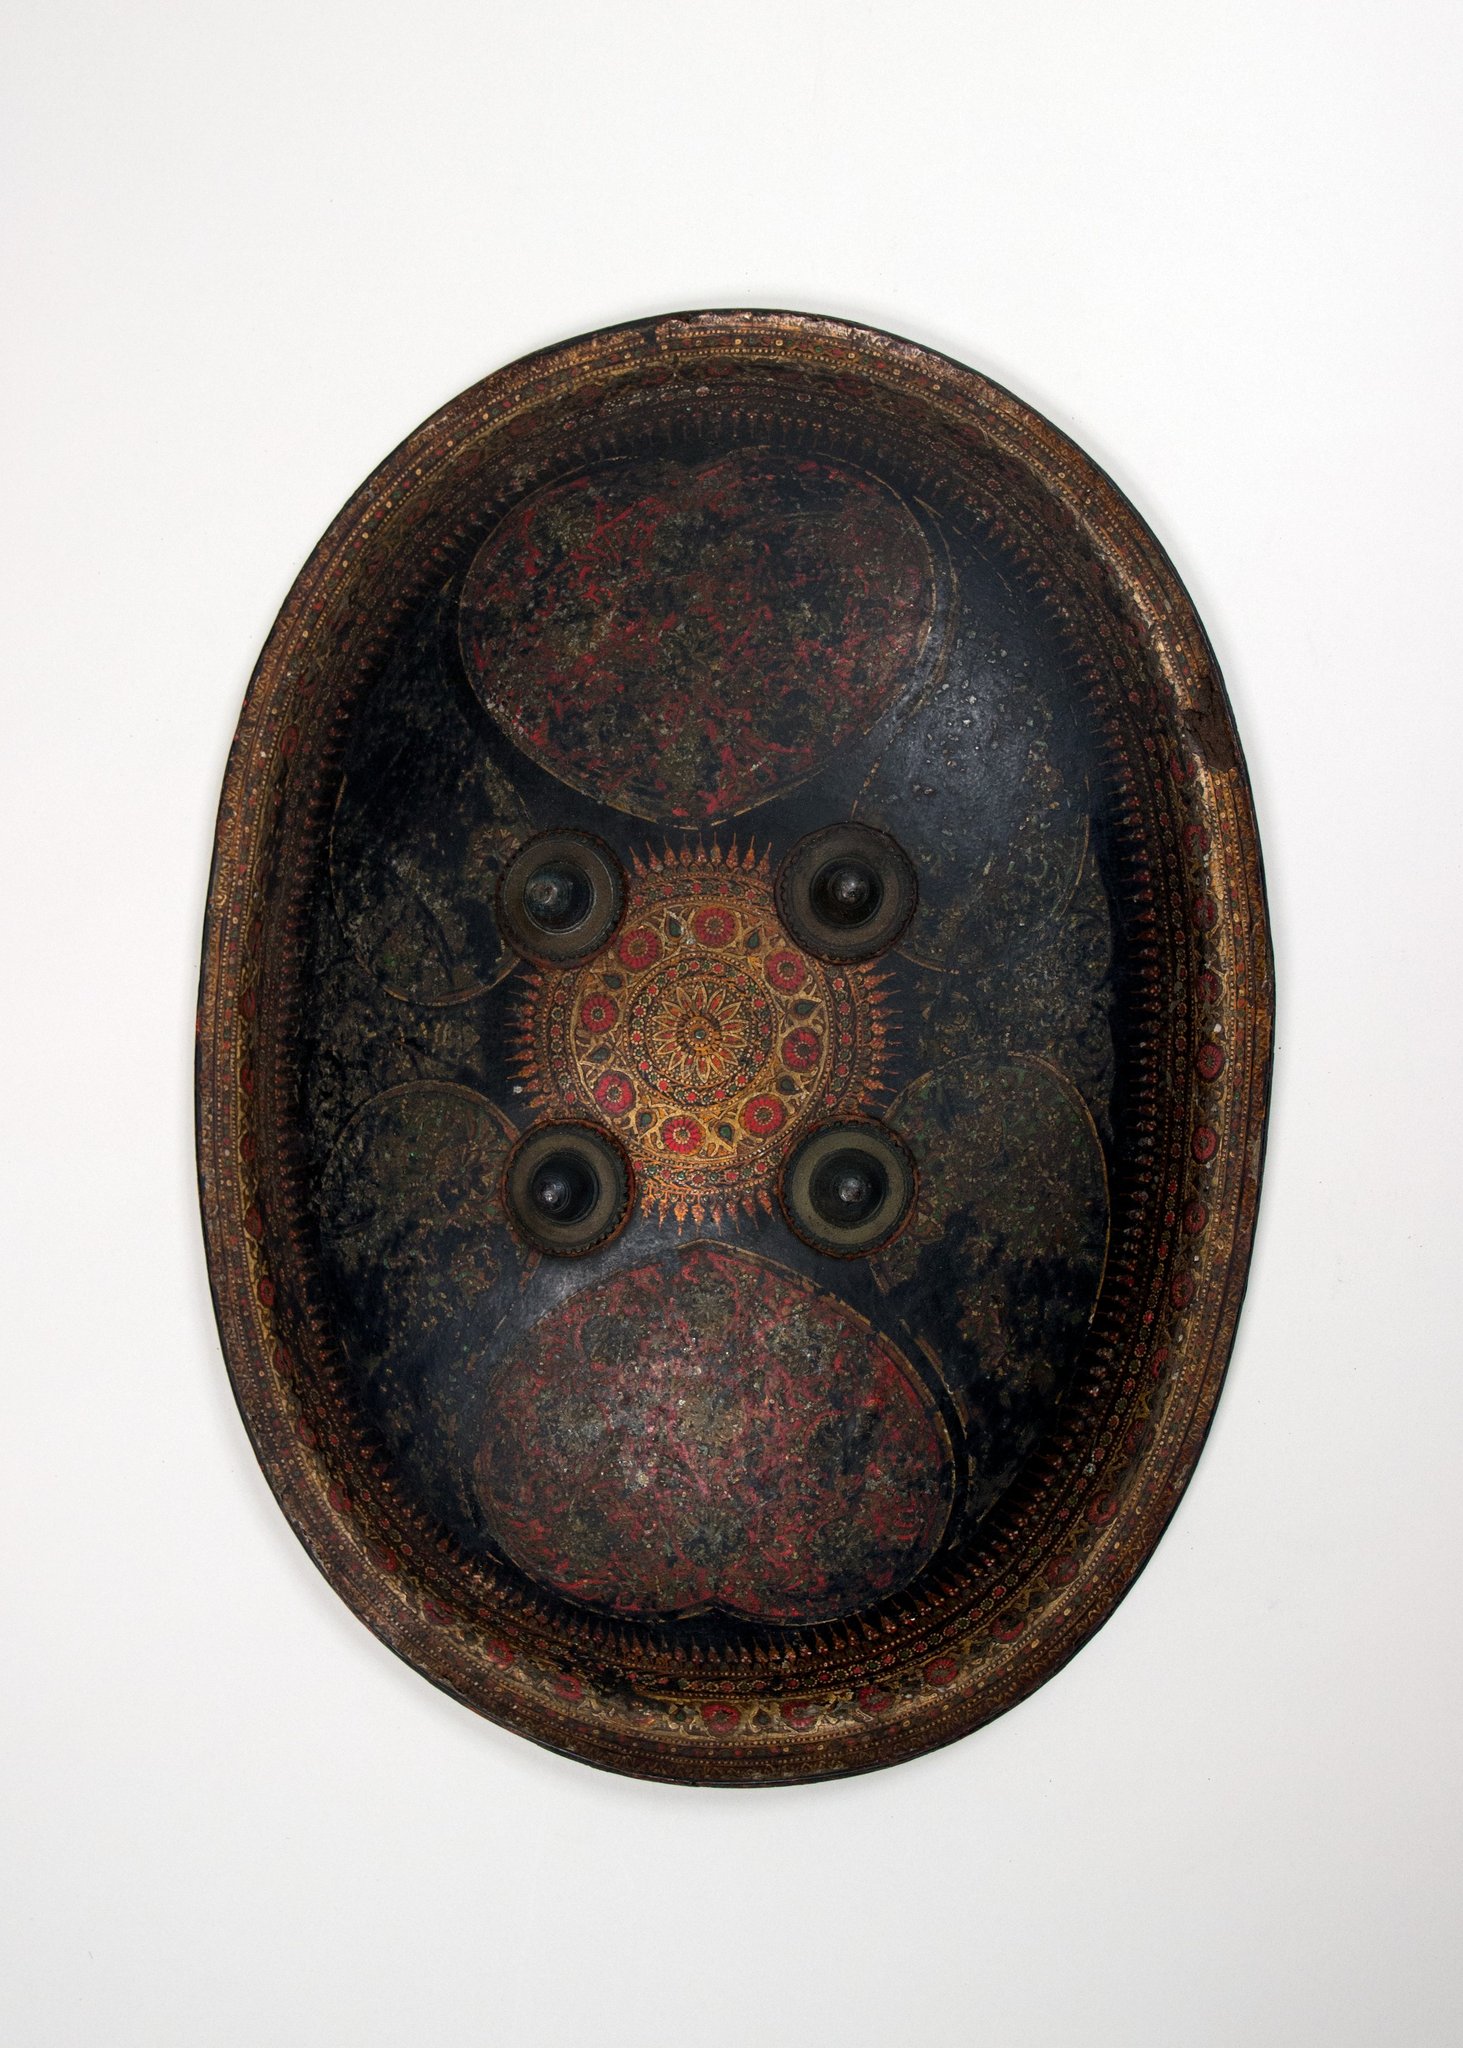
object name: shield dhàl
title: Shield (Dhàl)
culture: indian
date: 1701-1900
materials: copper alloy, leather, textile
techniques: polychromy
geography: india